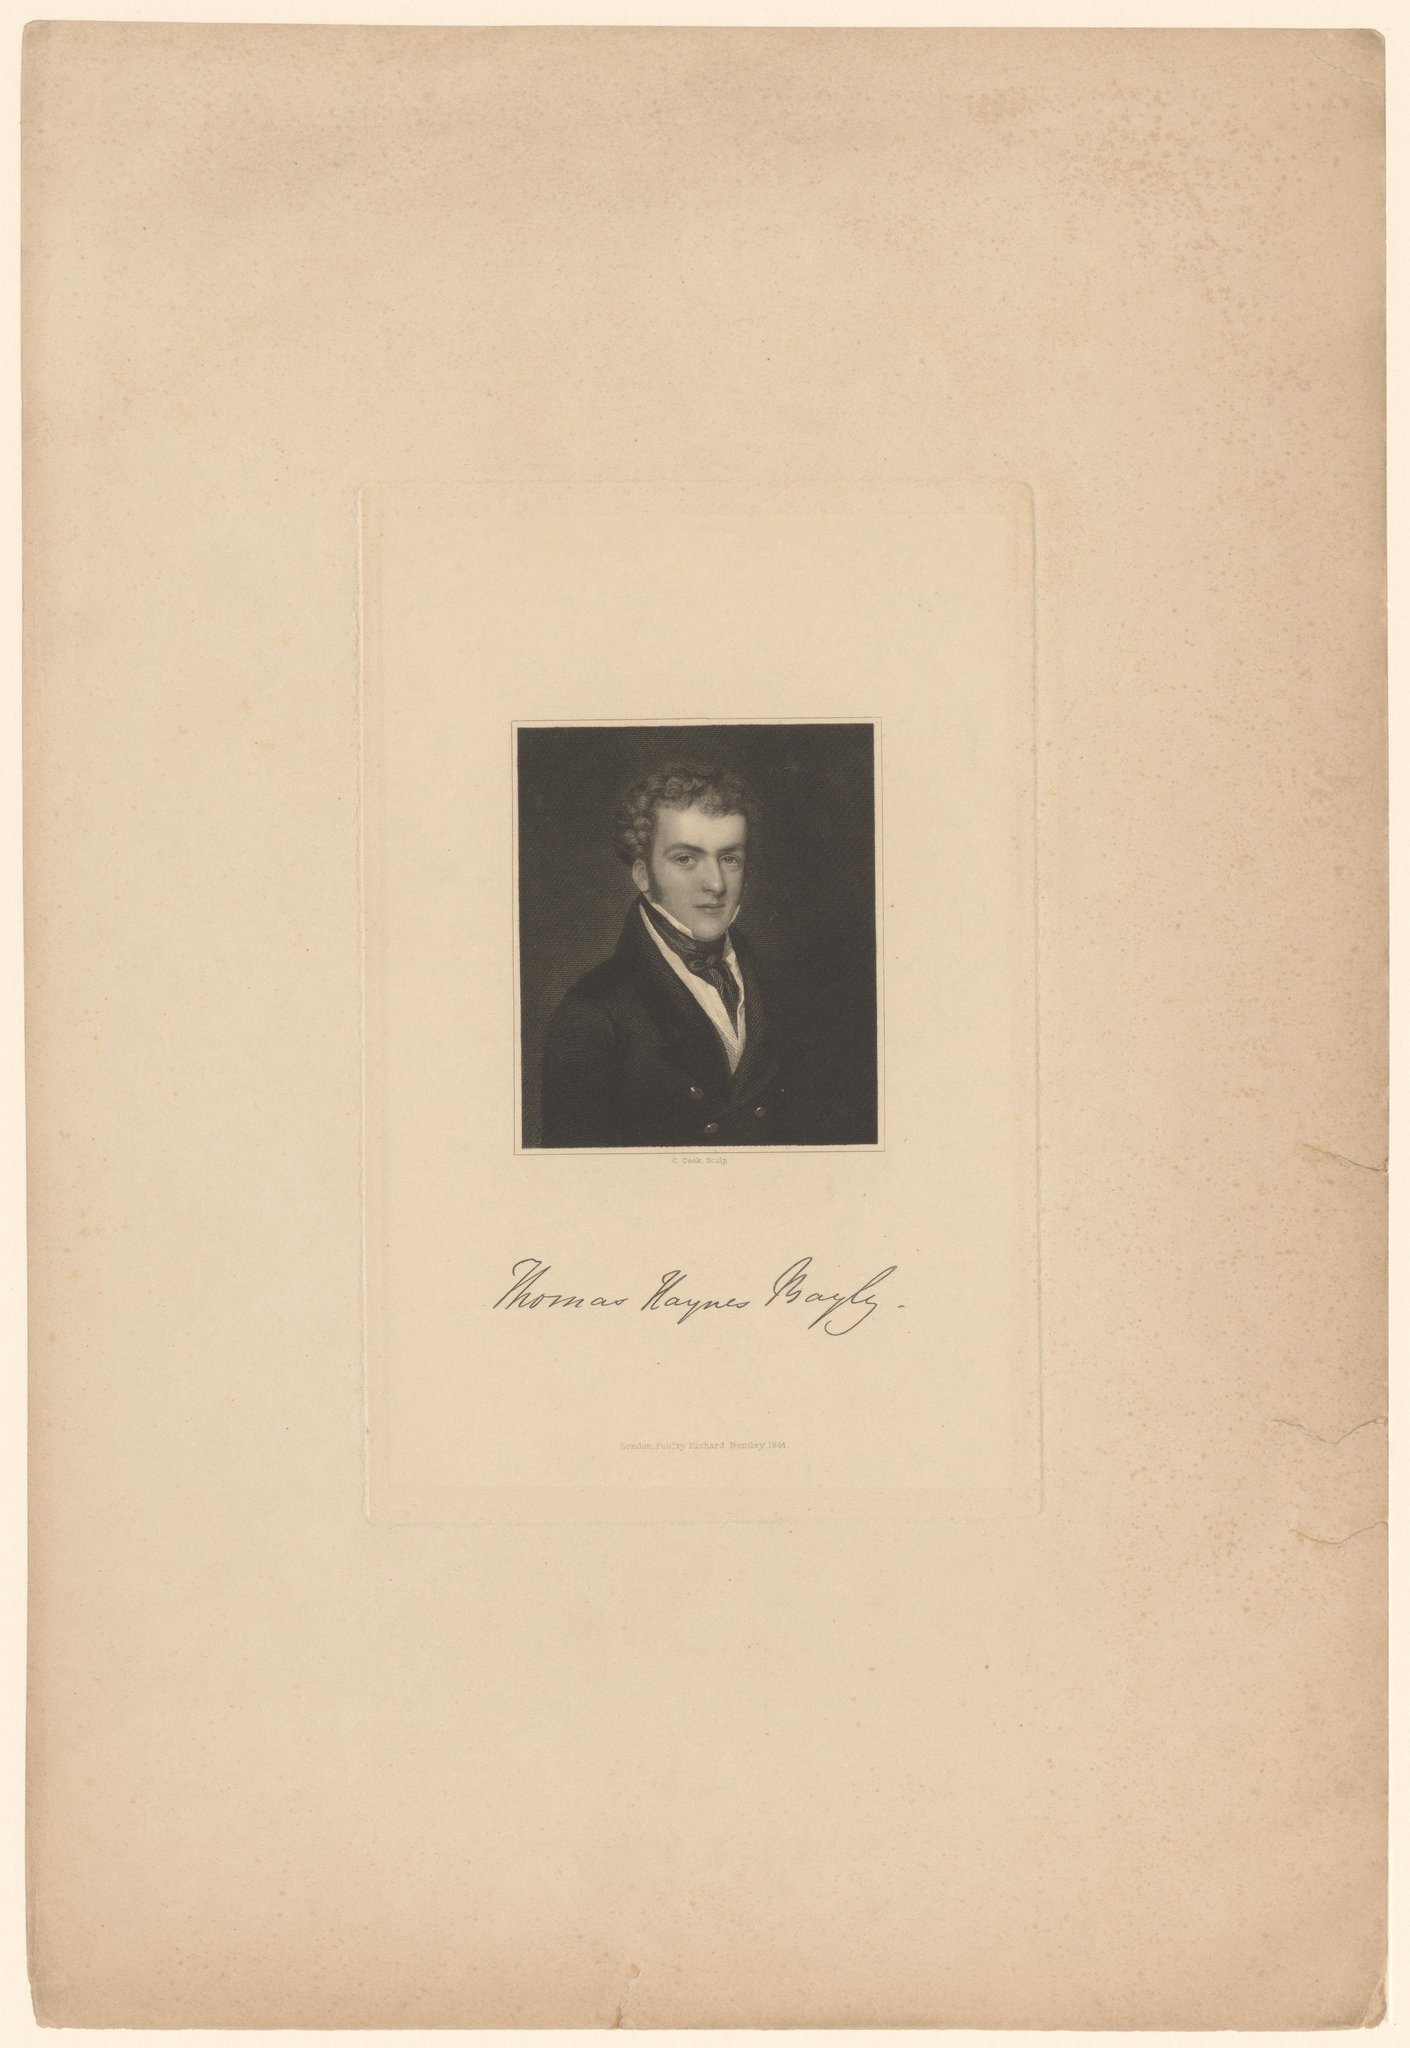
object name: print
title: Portret van Thomas Haynes Bayly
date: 1844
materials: paper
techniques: engraving, etching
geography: london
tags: england, historical persons, portrait of a writer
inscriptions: collector's mark: Lugt 2228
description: Een facsimile signatuur in de ondermarge.